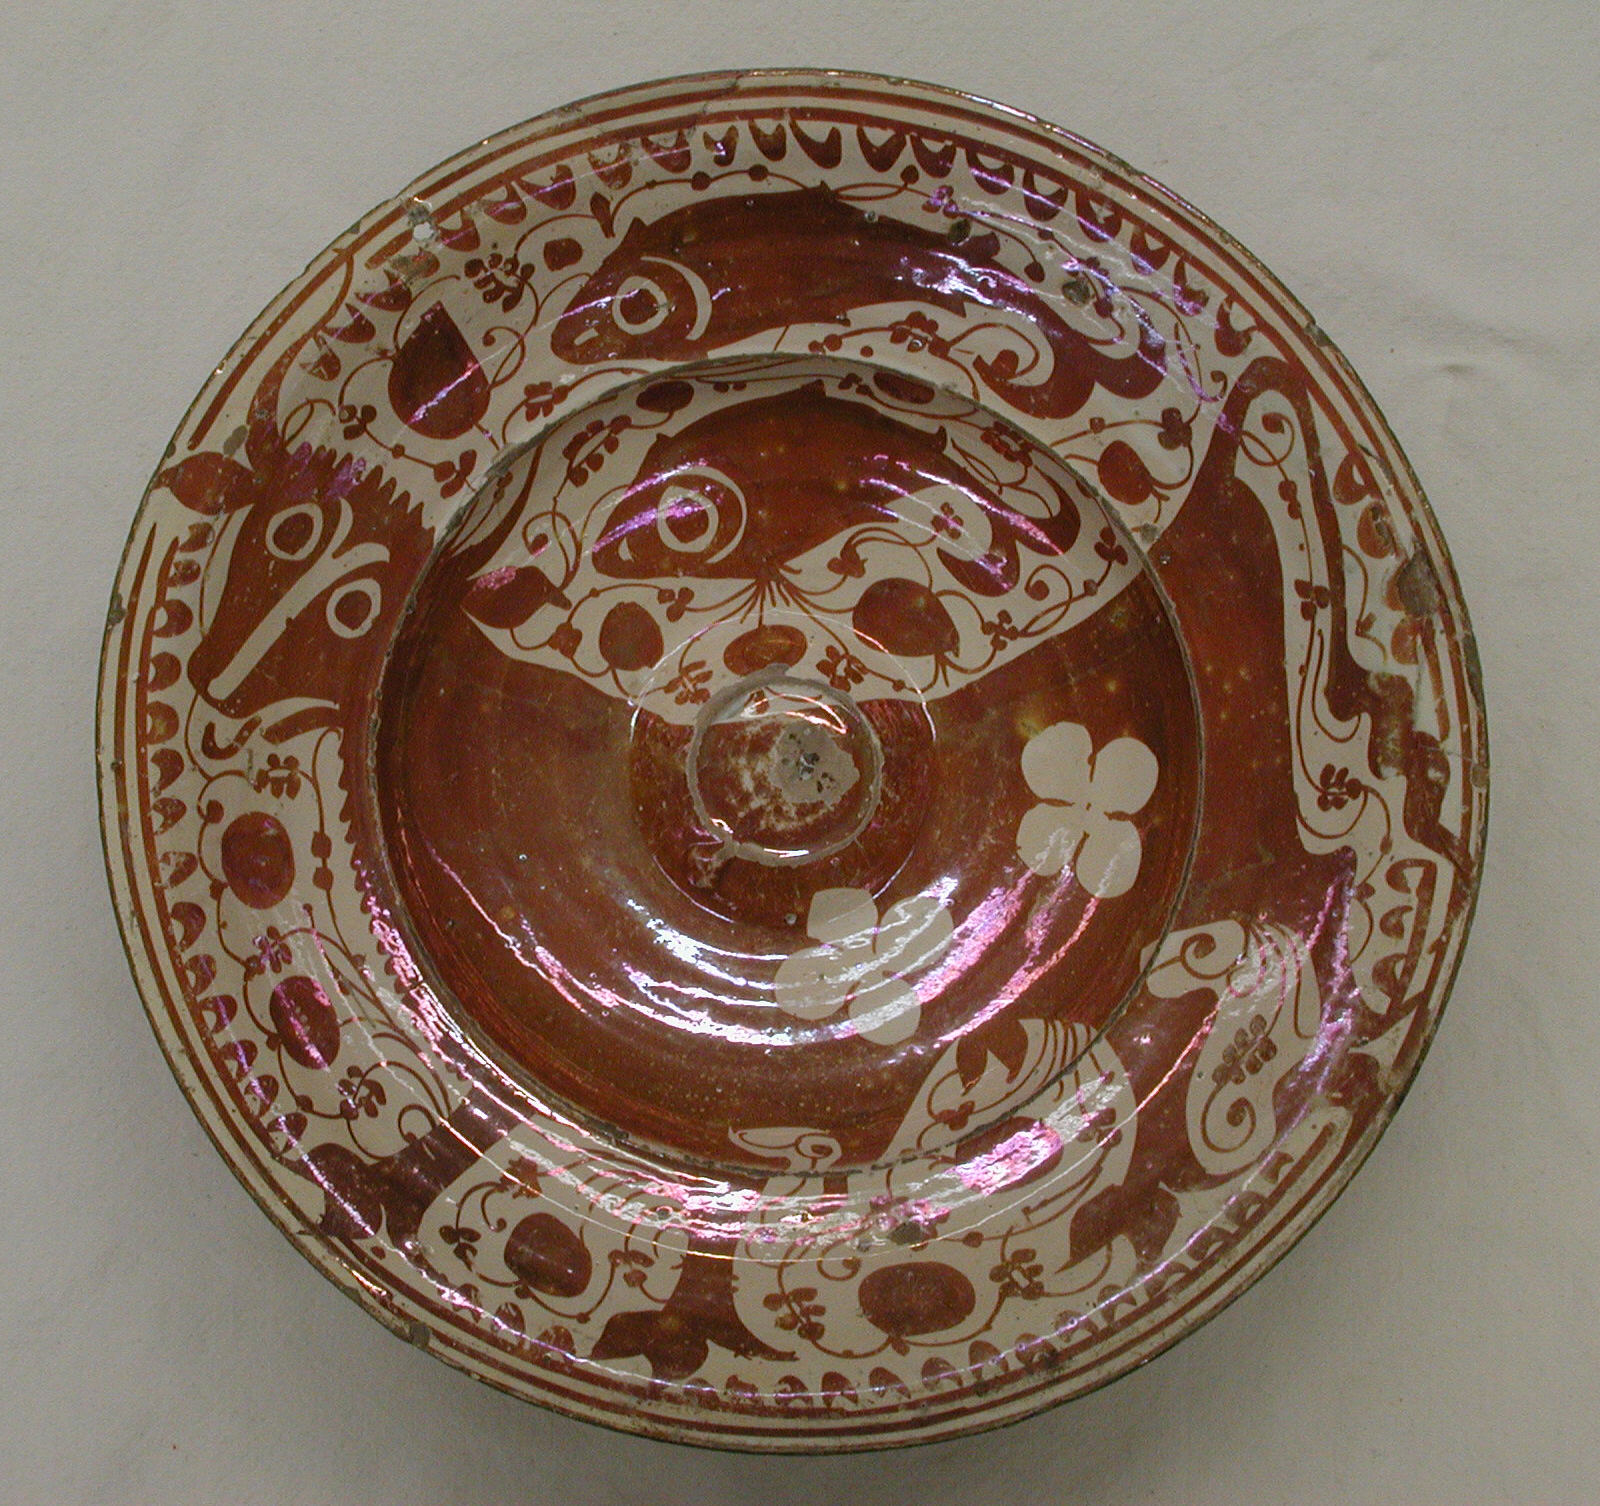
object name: dish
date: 1567-1633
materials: earthenware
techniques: luster painting, glazing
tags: fish